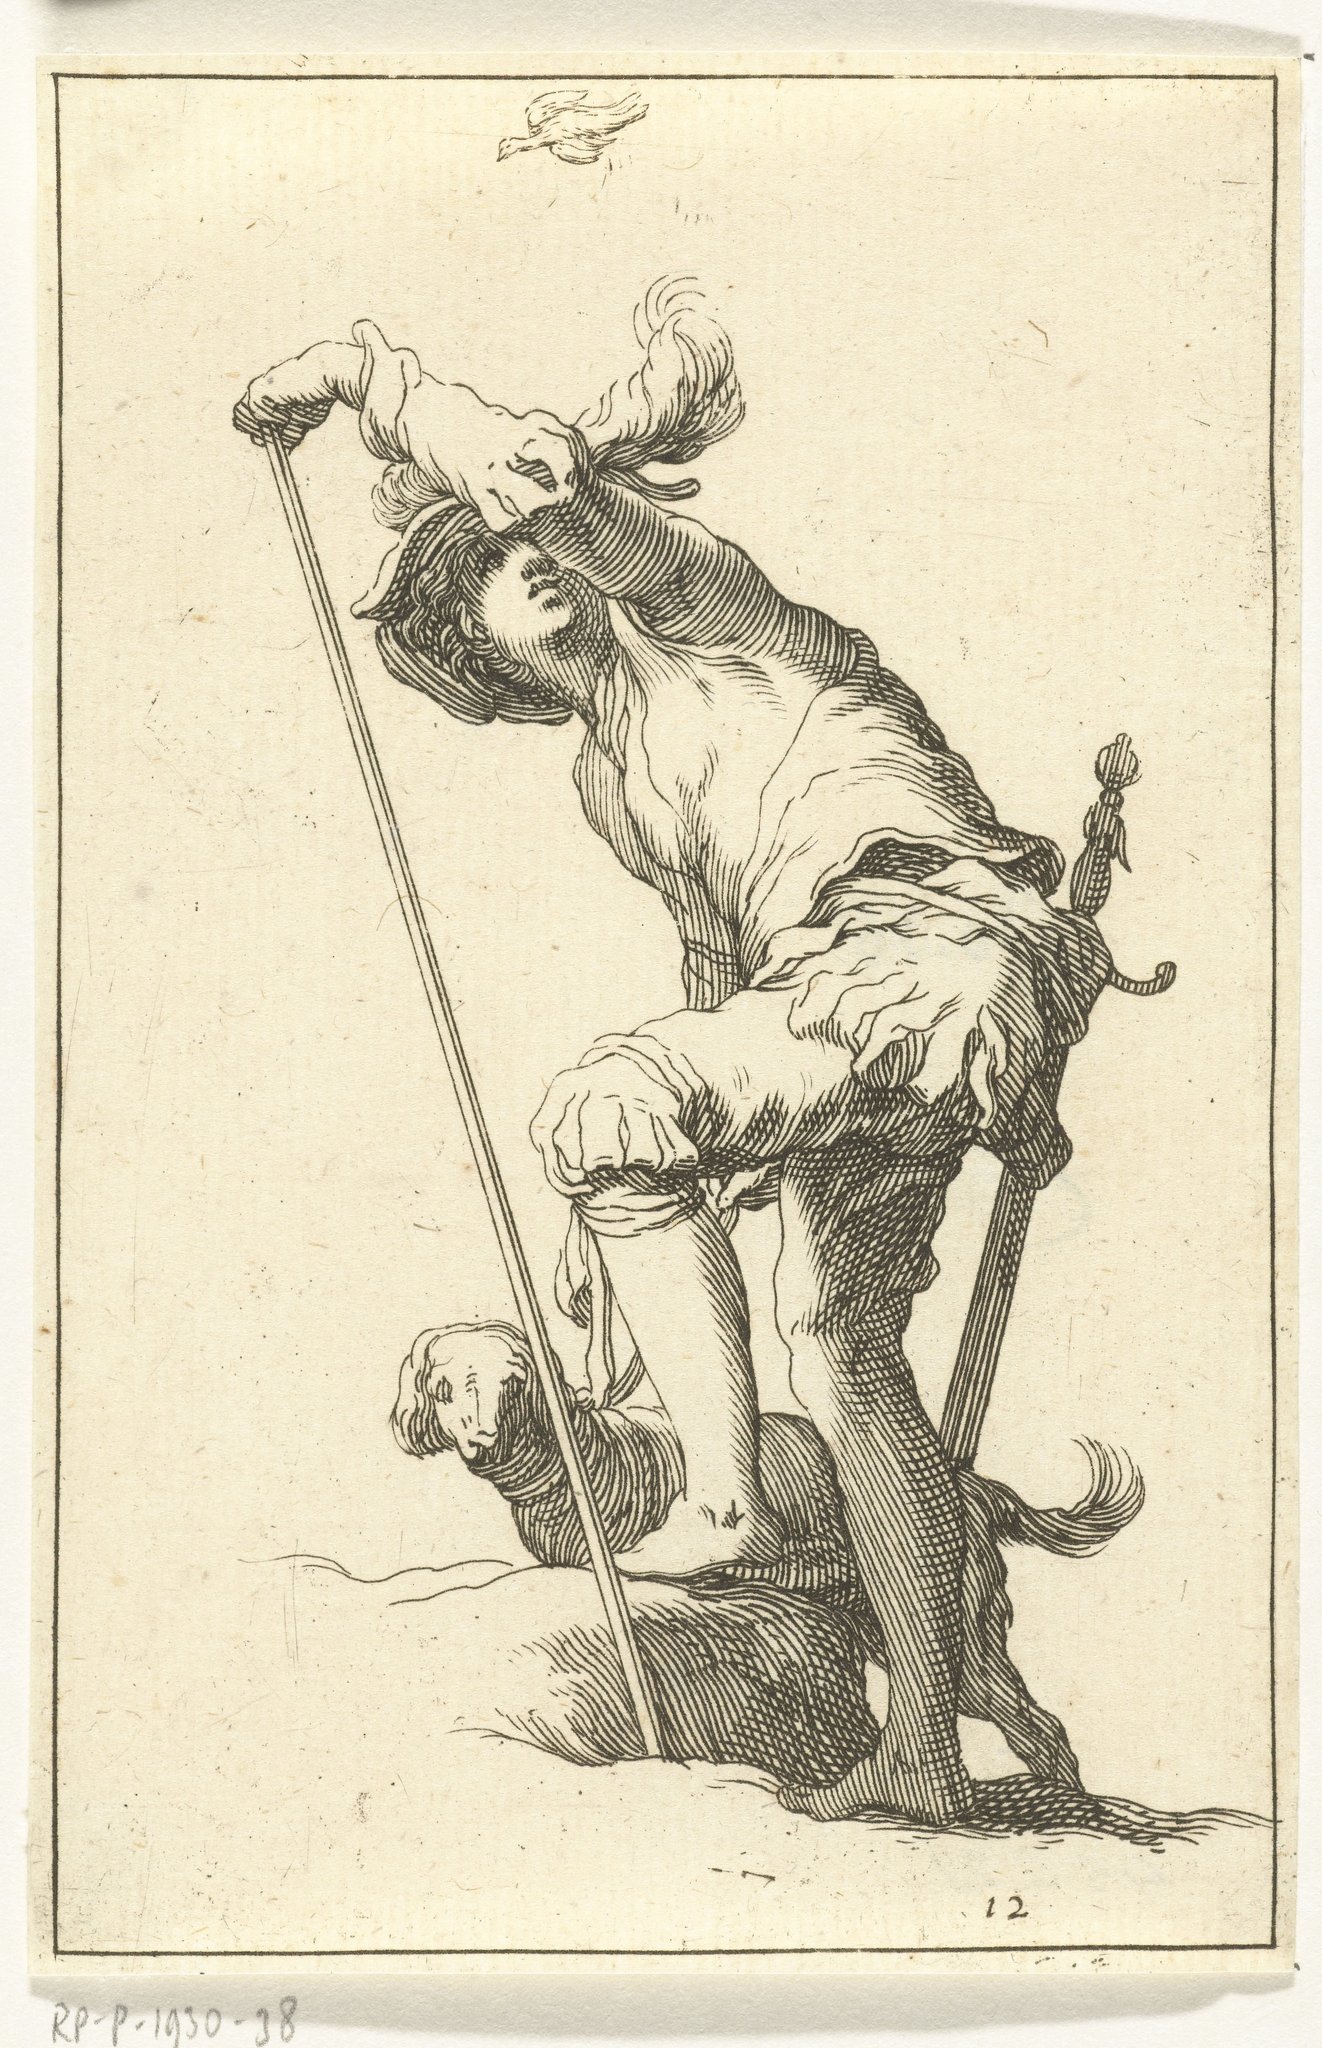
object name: print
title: Jonge soldaat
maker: frederick bloemaert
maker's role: print maker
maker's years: 1614-1669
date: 1635-1669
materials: paper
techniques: engraving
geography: utrecht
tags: dog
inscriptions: collector's mark: Lugt 2233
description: Een jonge man met stok en zwaard kijkt in de lucht naar een vogel. Naast hem een hond.